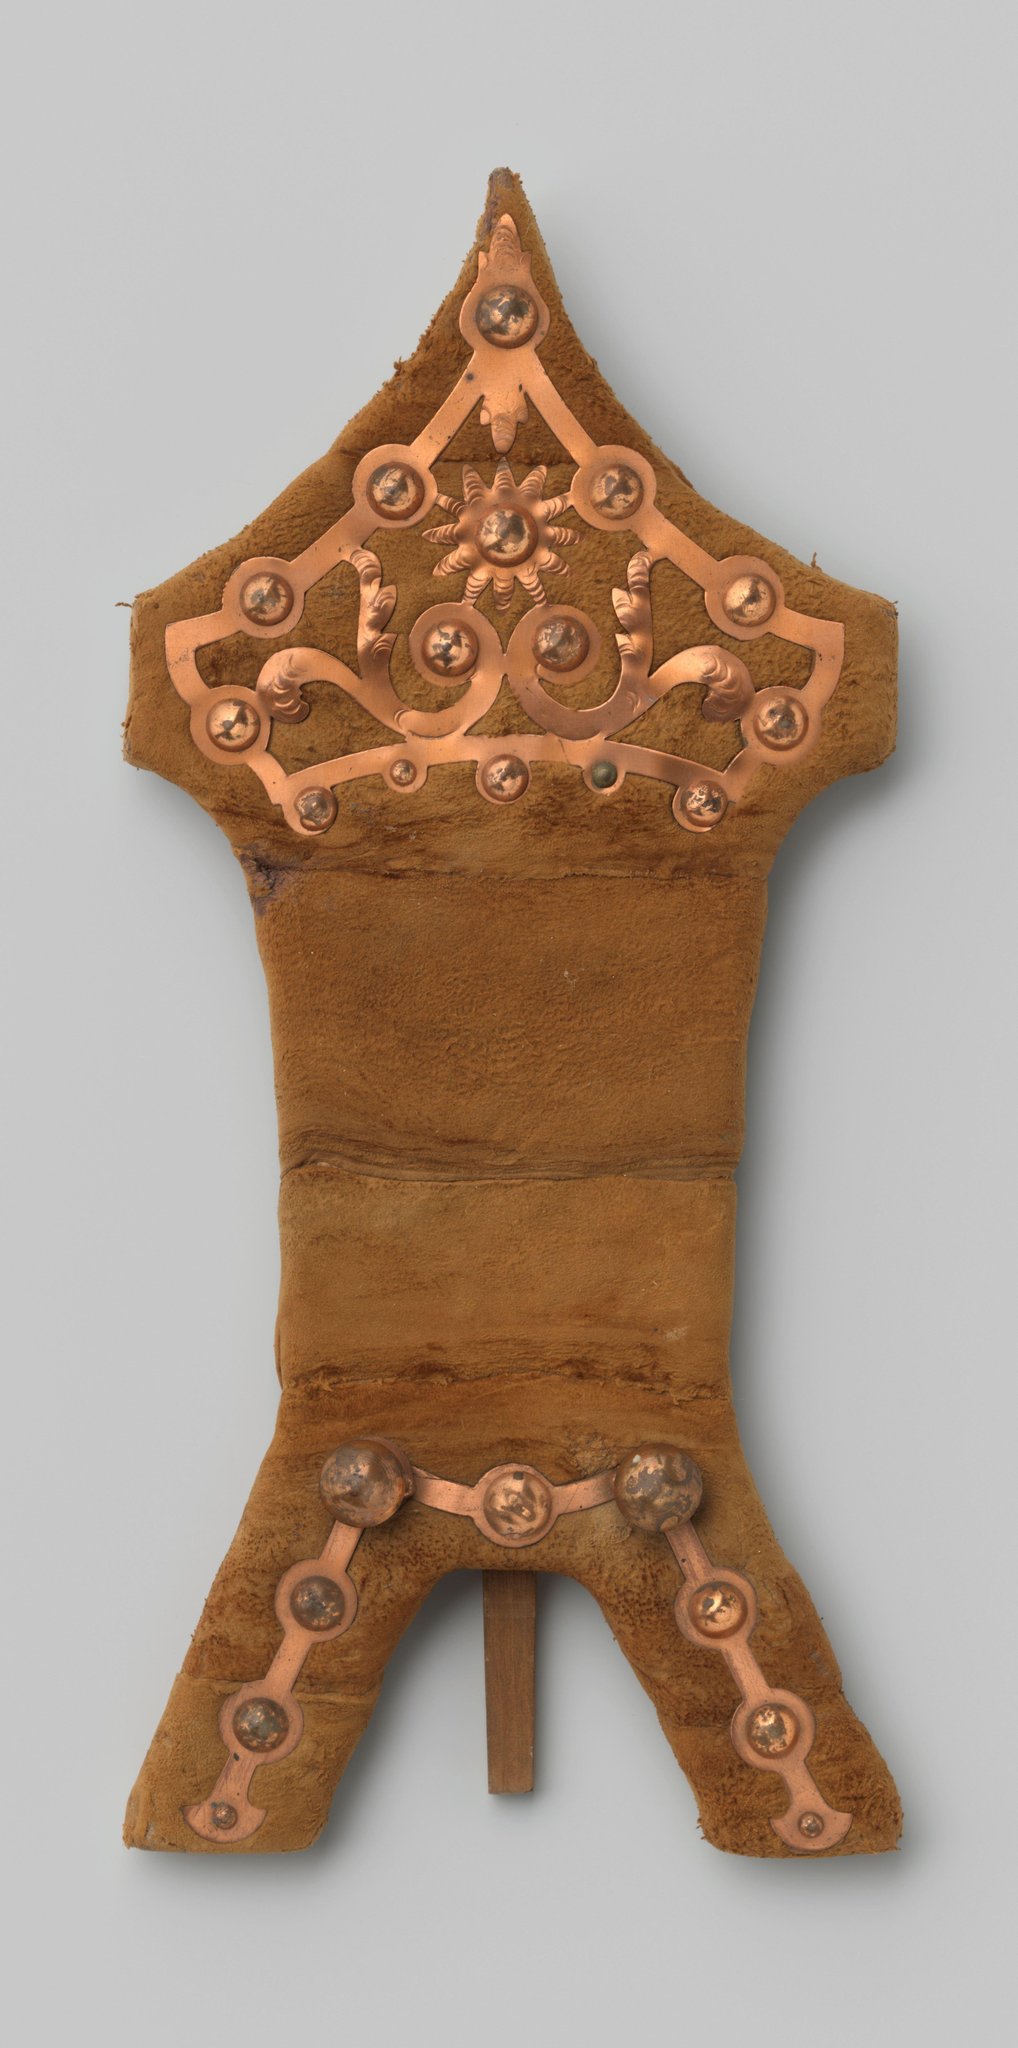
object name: standaard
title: Fotostandaard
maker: Anonymous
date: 1880-1900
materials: leather, metal, wood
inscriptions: inscription: ‘gekocht april 1969 [...] A'dam f8.50/ [...]’